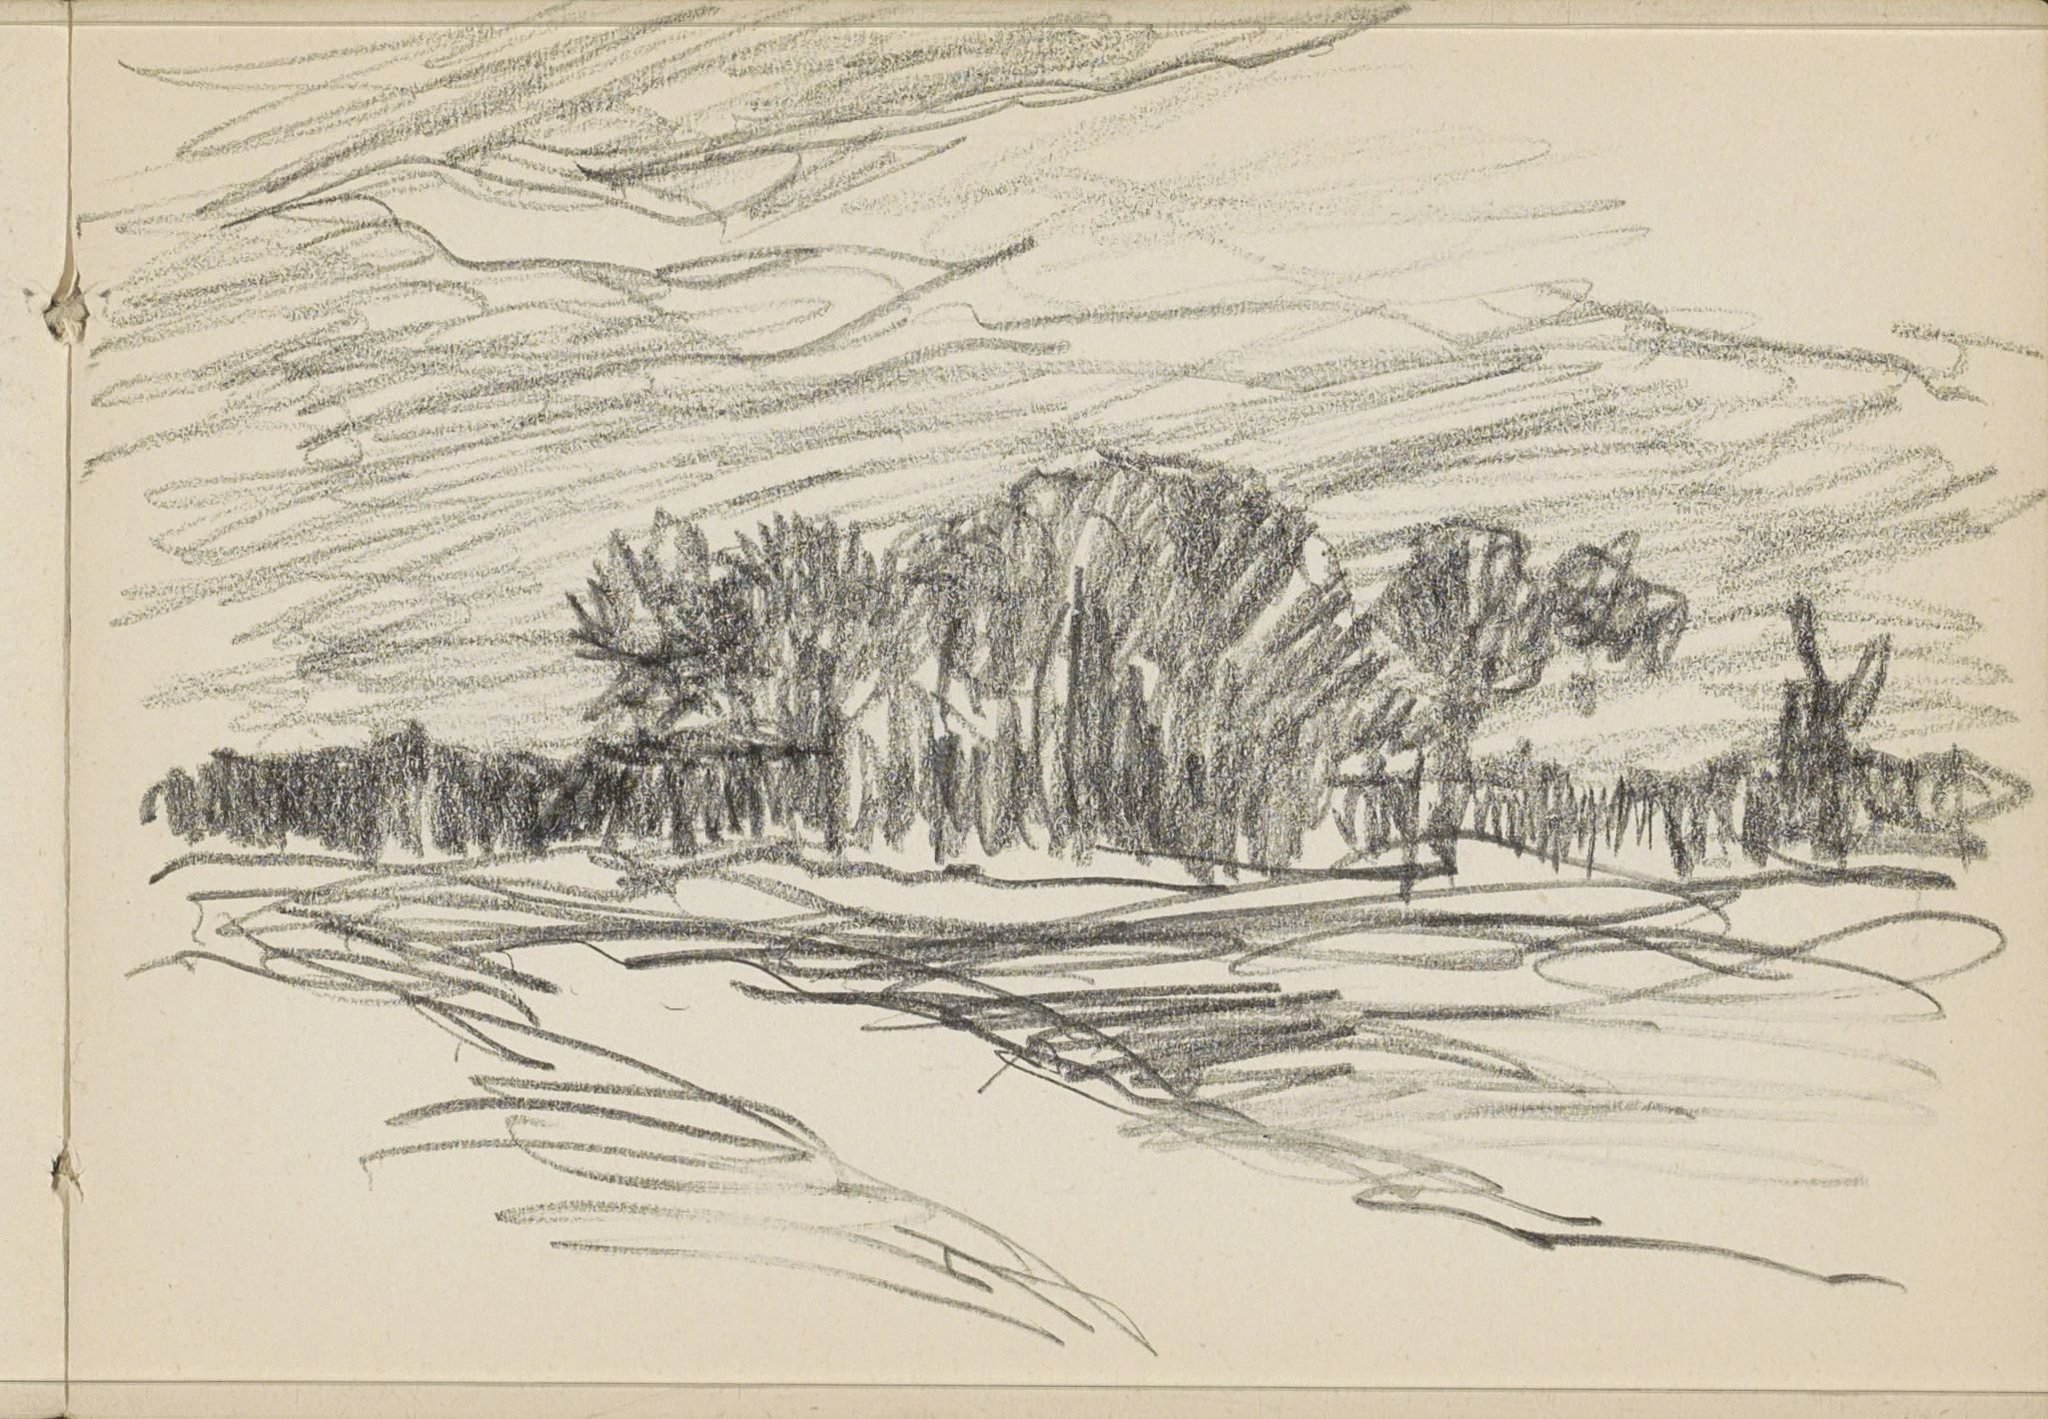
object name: sketchbook leaf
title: Landschap met bomen en een molen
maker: alexander shilling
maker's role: draughtsman, print maker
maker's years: 1859-1937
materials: chalk, paper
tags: trees, windmill in landscape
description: Blad 20 recto uit een schetsboek met 30 bladen.